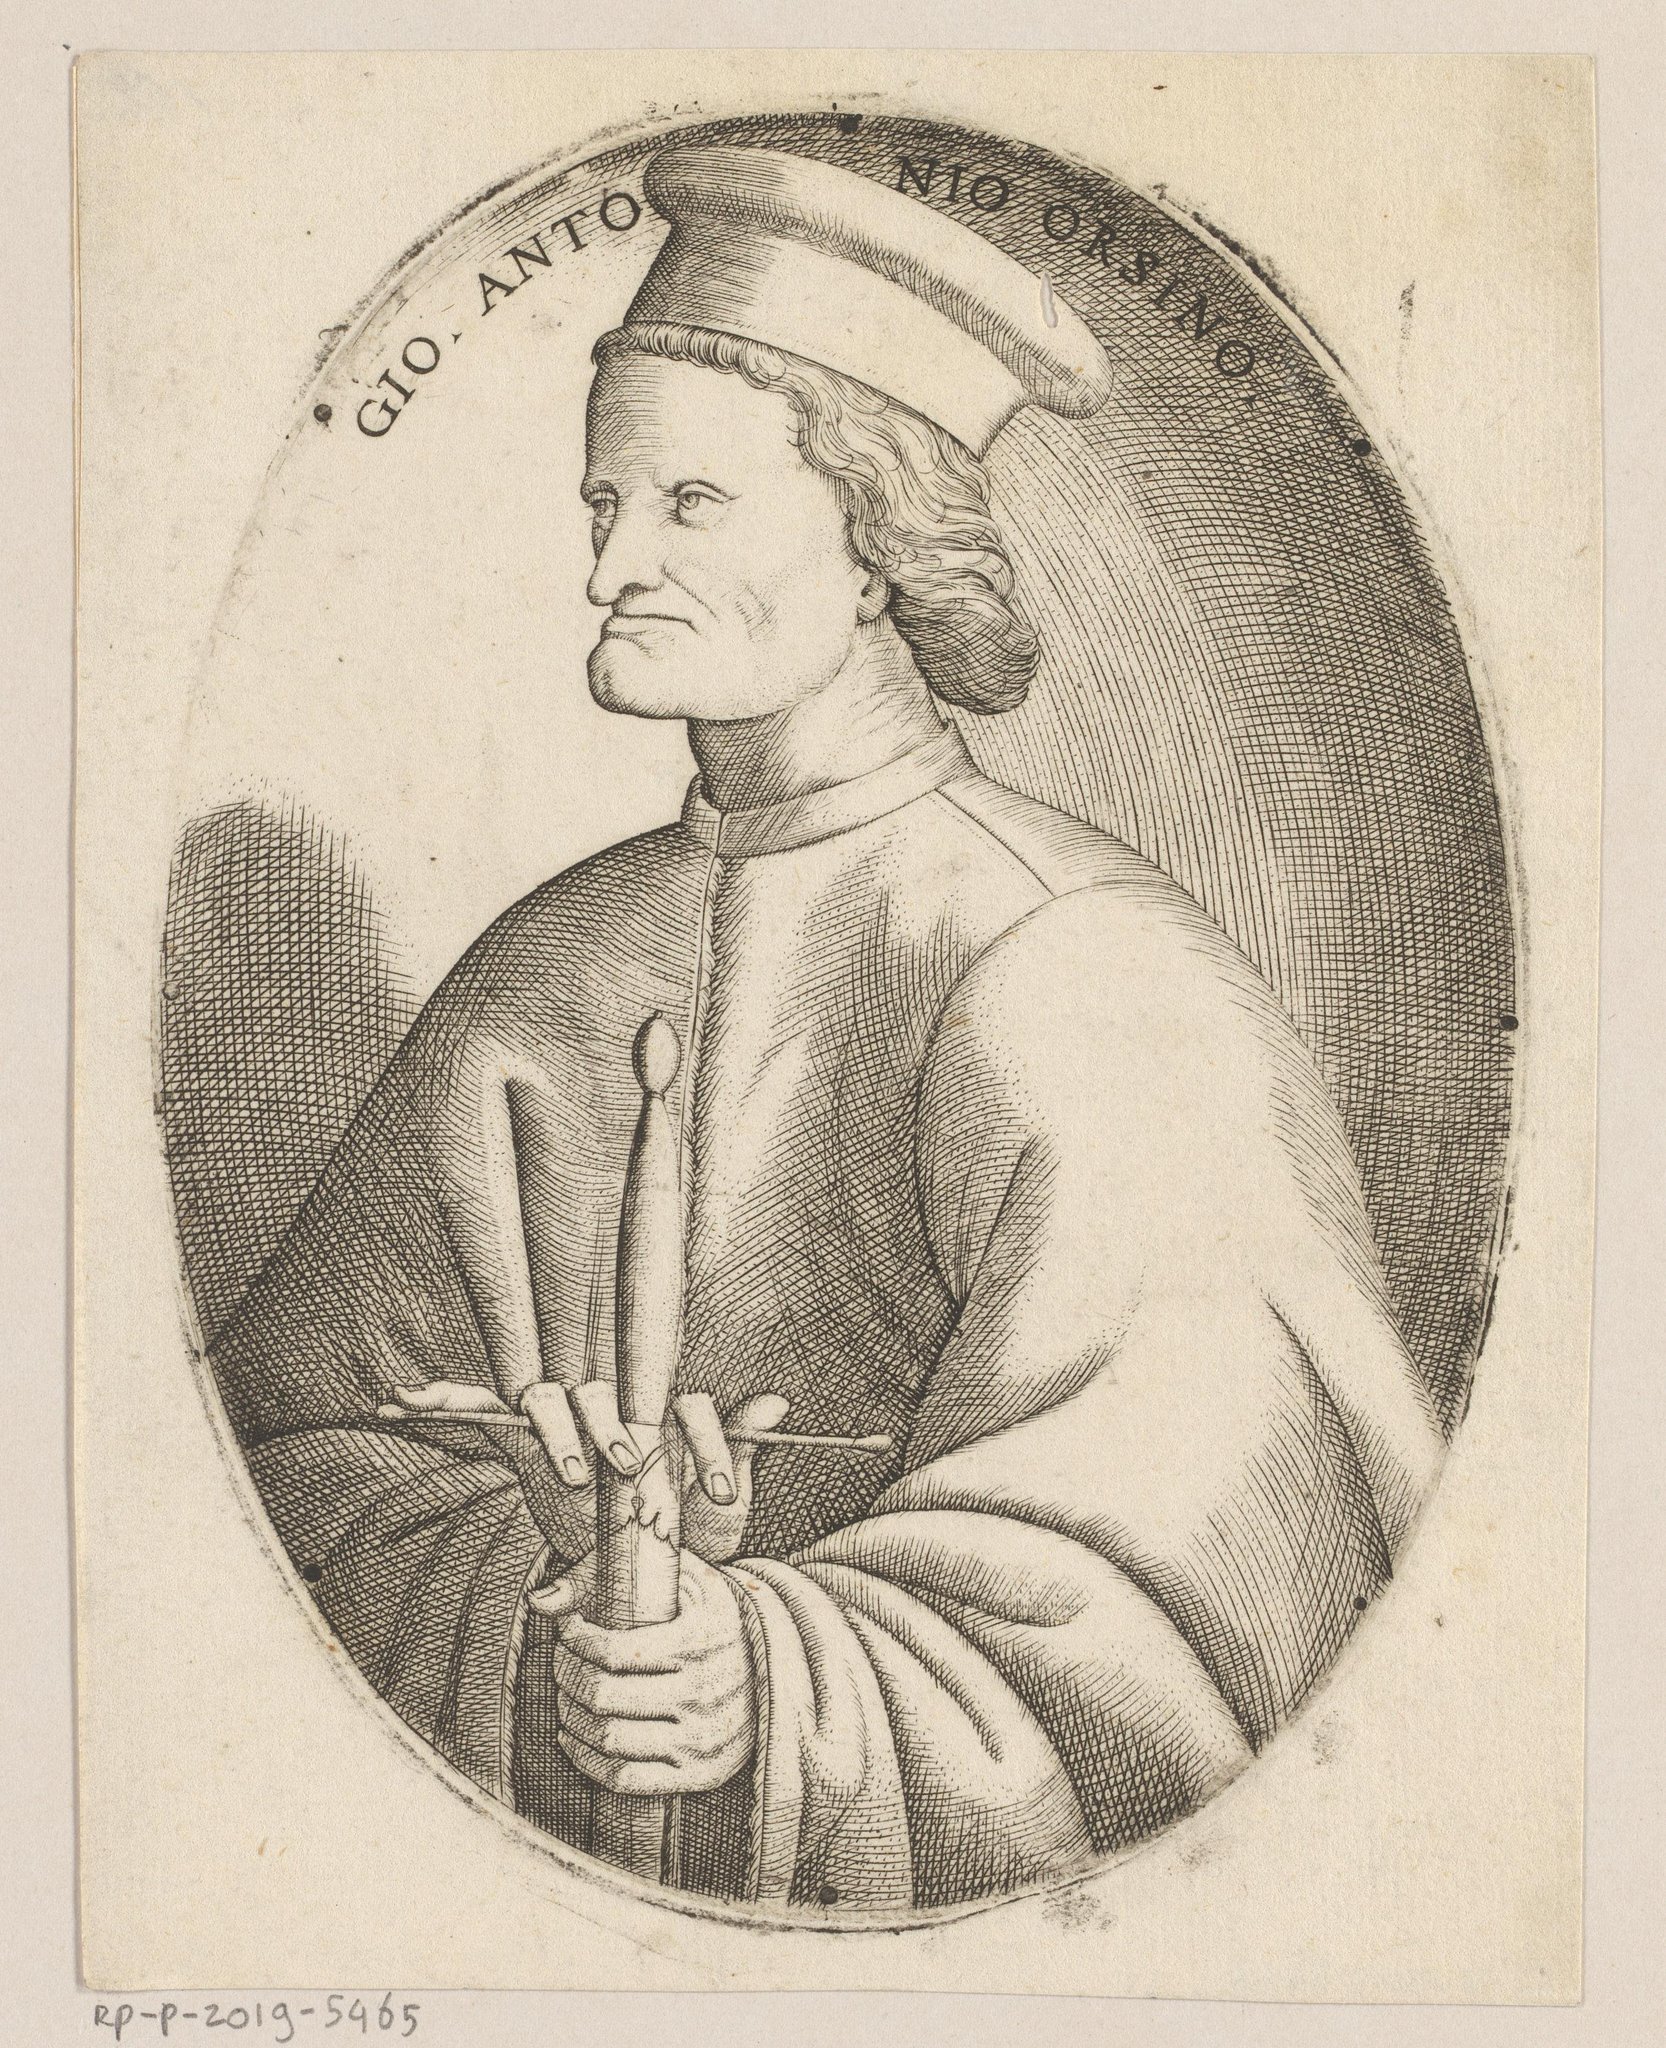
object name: print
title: Portret van Giovanni Antonio Orsini del Balzo, prins van Taranto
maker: niccolò nelli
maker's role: print maker, publisher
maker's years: 1535-1585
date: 1565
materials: paper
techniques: engraving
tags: lecce, commander-in-chief, general, marshal, historical persons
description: Prent gebruikt in: Sansovino, Francesco. De gli huomini illustri della casa Orsina. Venetië: Bernardino & Filippo Stagnini en Domenico Nicolini,1565, dl. 4.